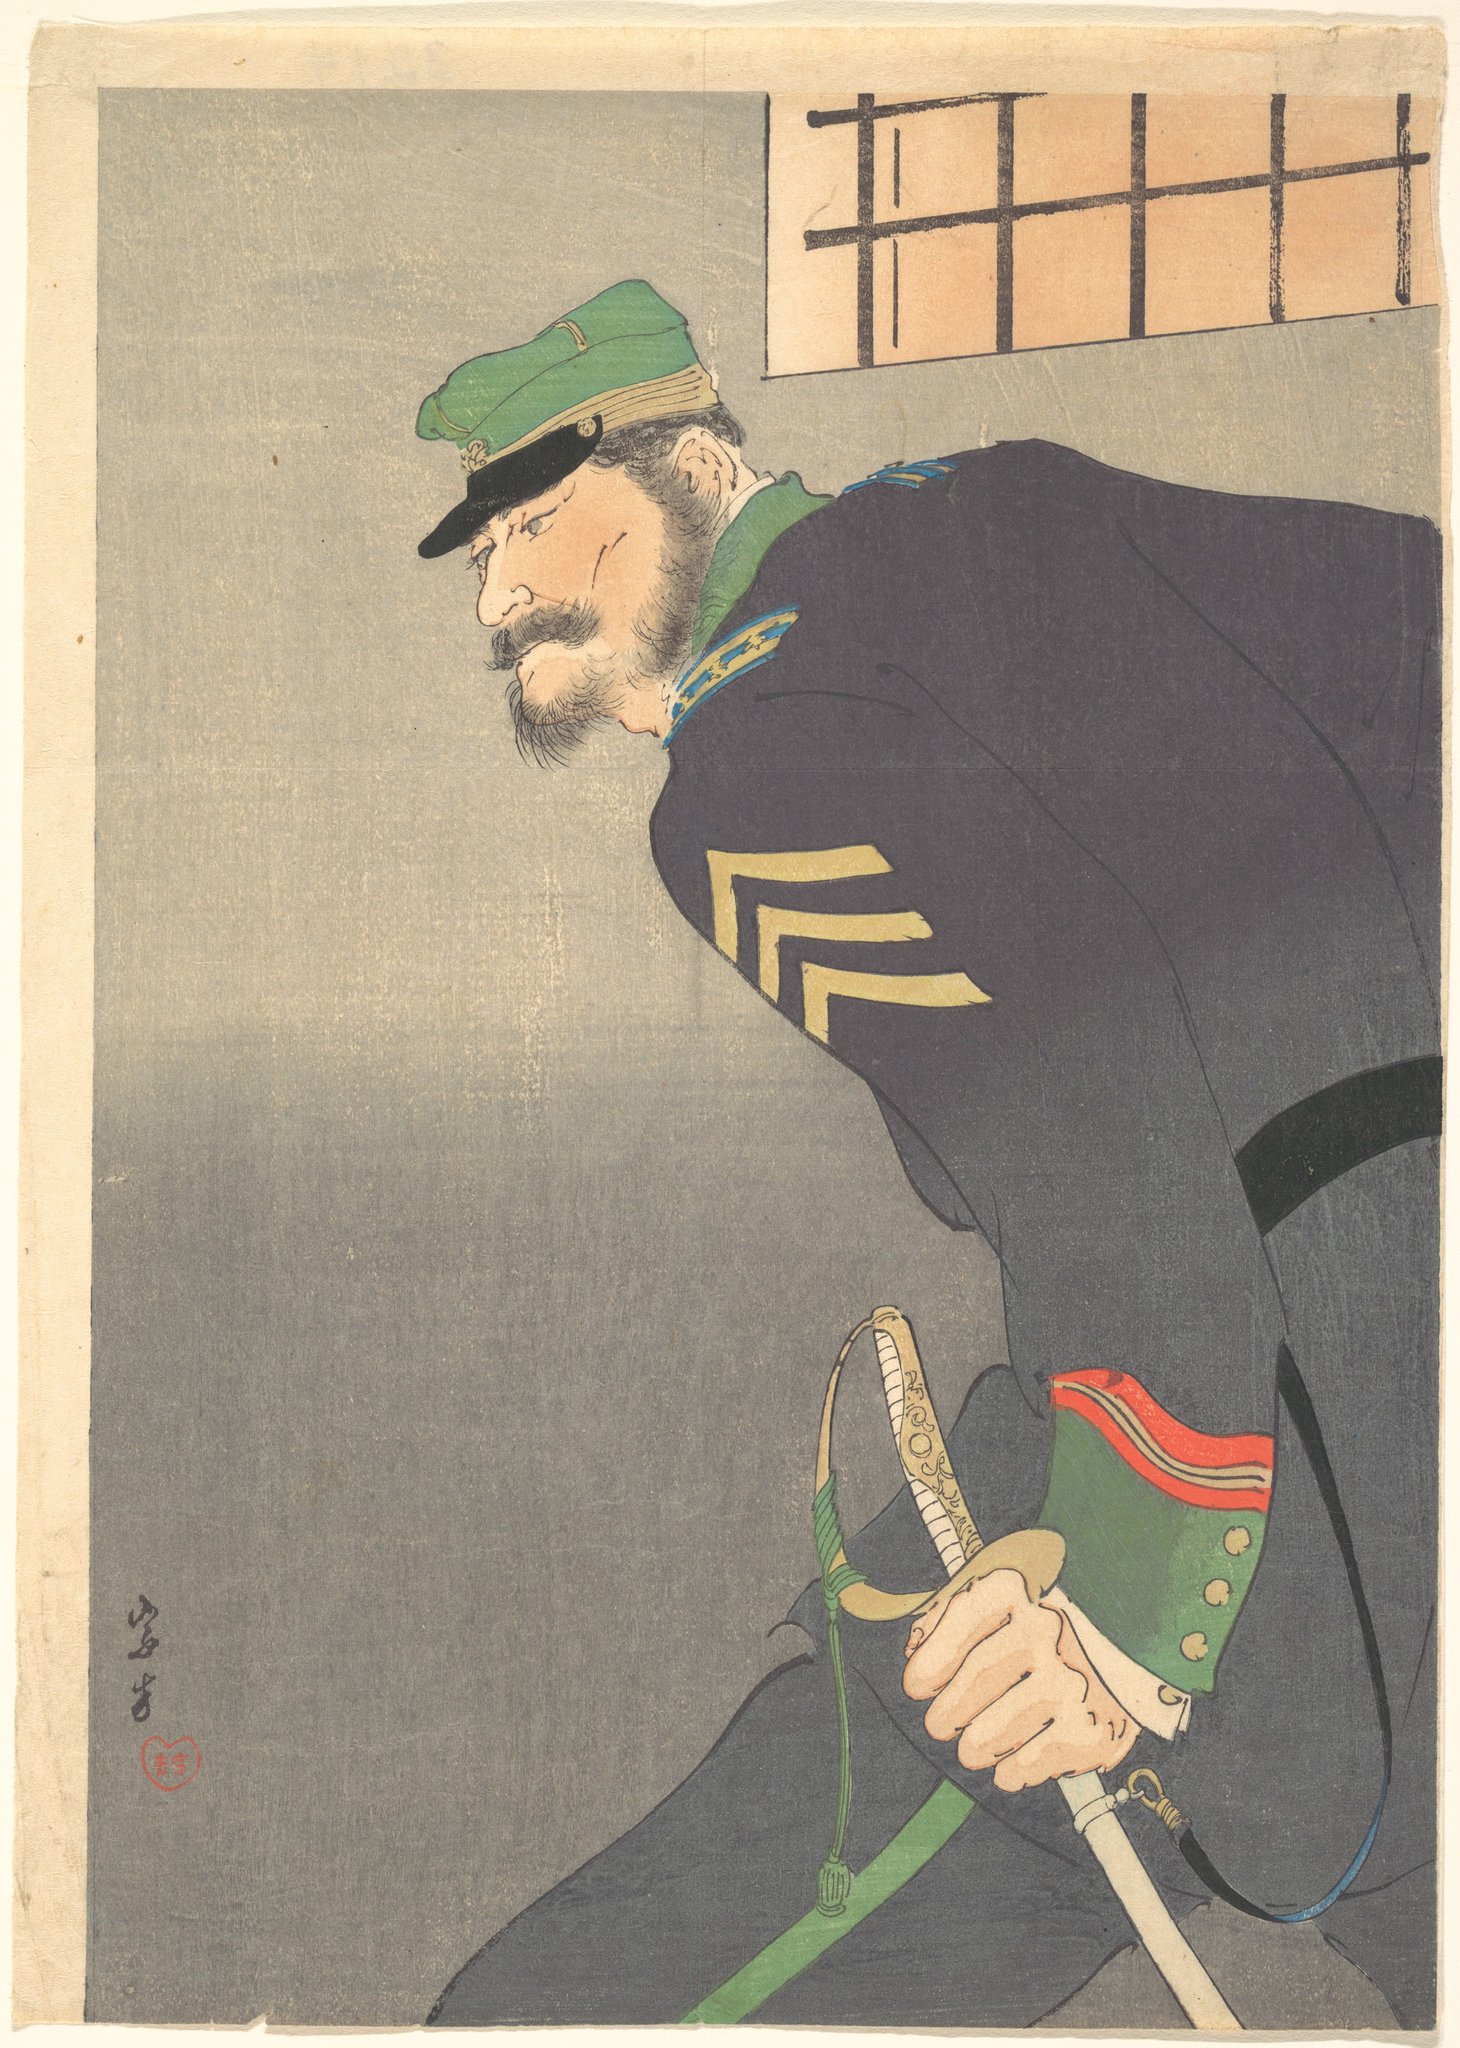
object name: print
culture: japanese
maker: munakata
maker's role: artist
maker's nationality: japanese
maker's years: 1868-1912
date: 1906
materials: ink, paper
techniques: woodblock print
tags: soldiers,swords,men